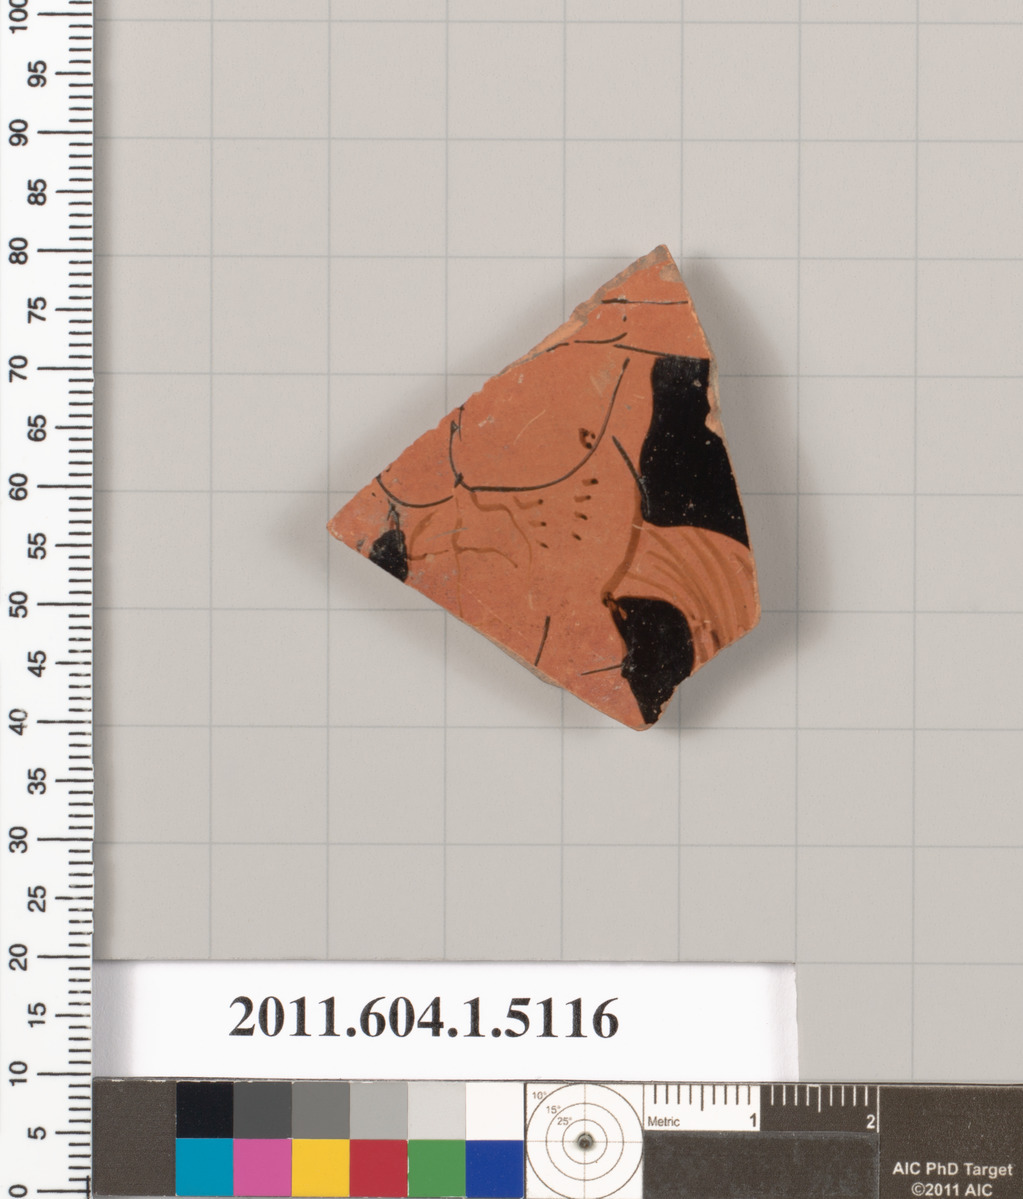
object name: kylix fragment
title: Terracotta fragment of a kylix (drinking cup)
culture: greek, attic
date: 467-435 BCE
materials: terracotta